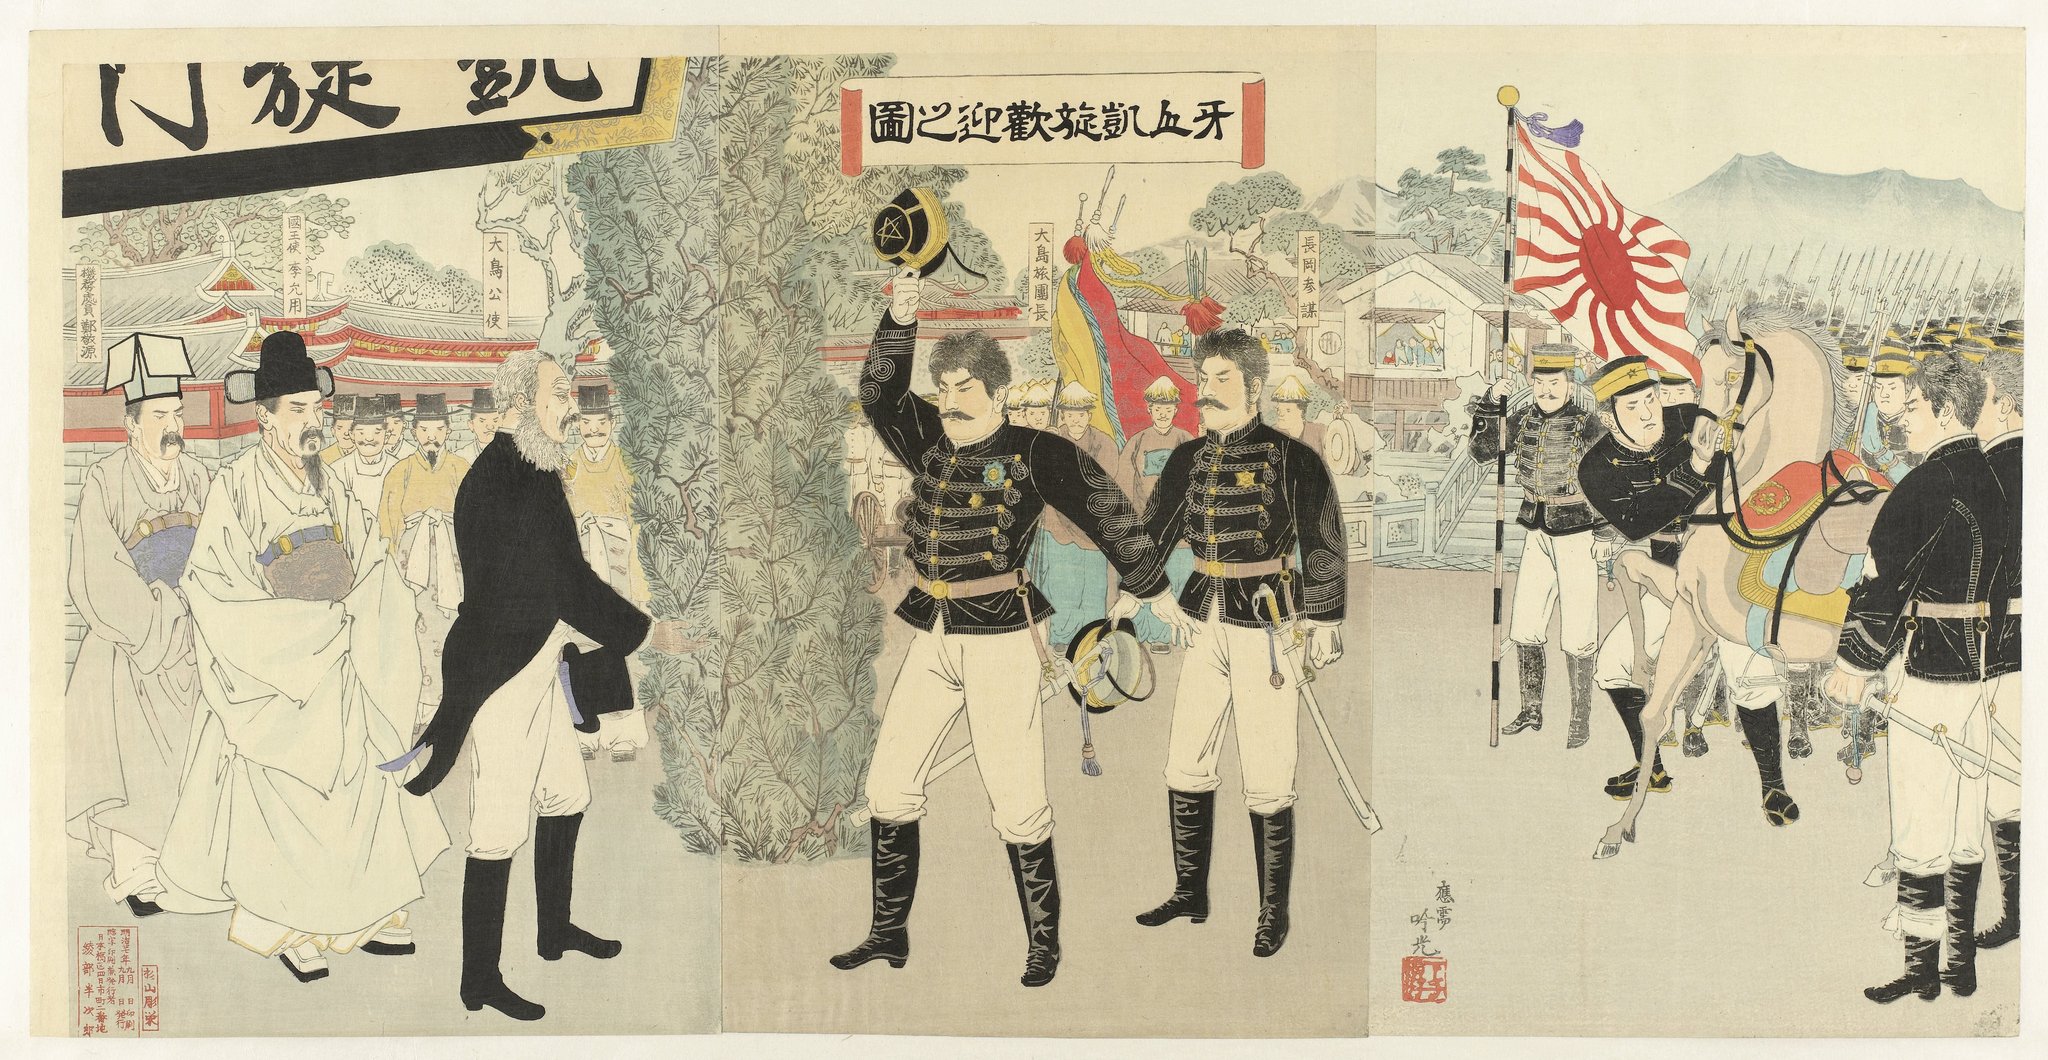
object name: print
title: Verwelkoming van het triomfantelijke Japanse leger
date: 1894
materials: paper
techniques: woodcut, polish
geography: japan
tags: city-view, and landscape with man-made constructions, being welcomed ~ travelling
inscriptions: date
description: Koreaanse ambtenaren verwelkomen het Japanse leger onder leiding van Generaal-Majoor Oshima Yoshimasa. Het Japanse leger arriveerde op 5 augustus 1894 in Seoul waar zij zich presenteerde aan de Koreaanse koning.